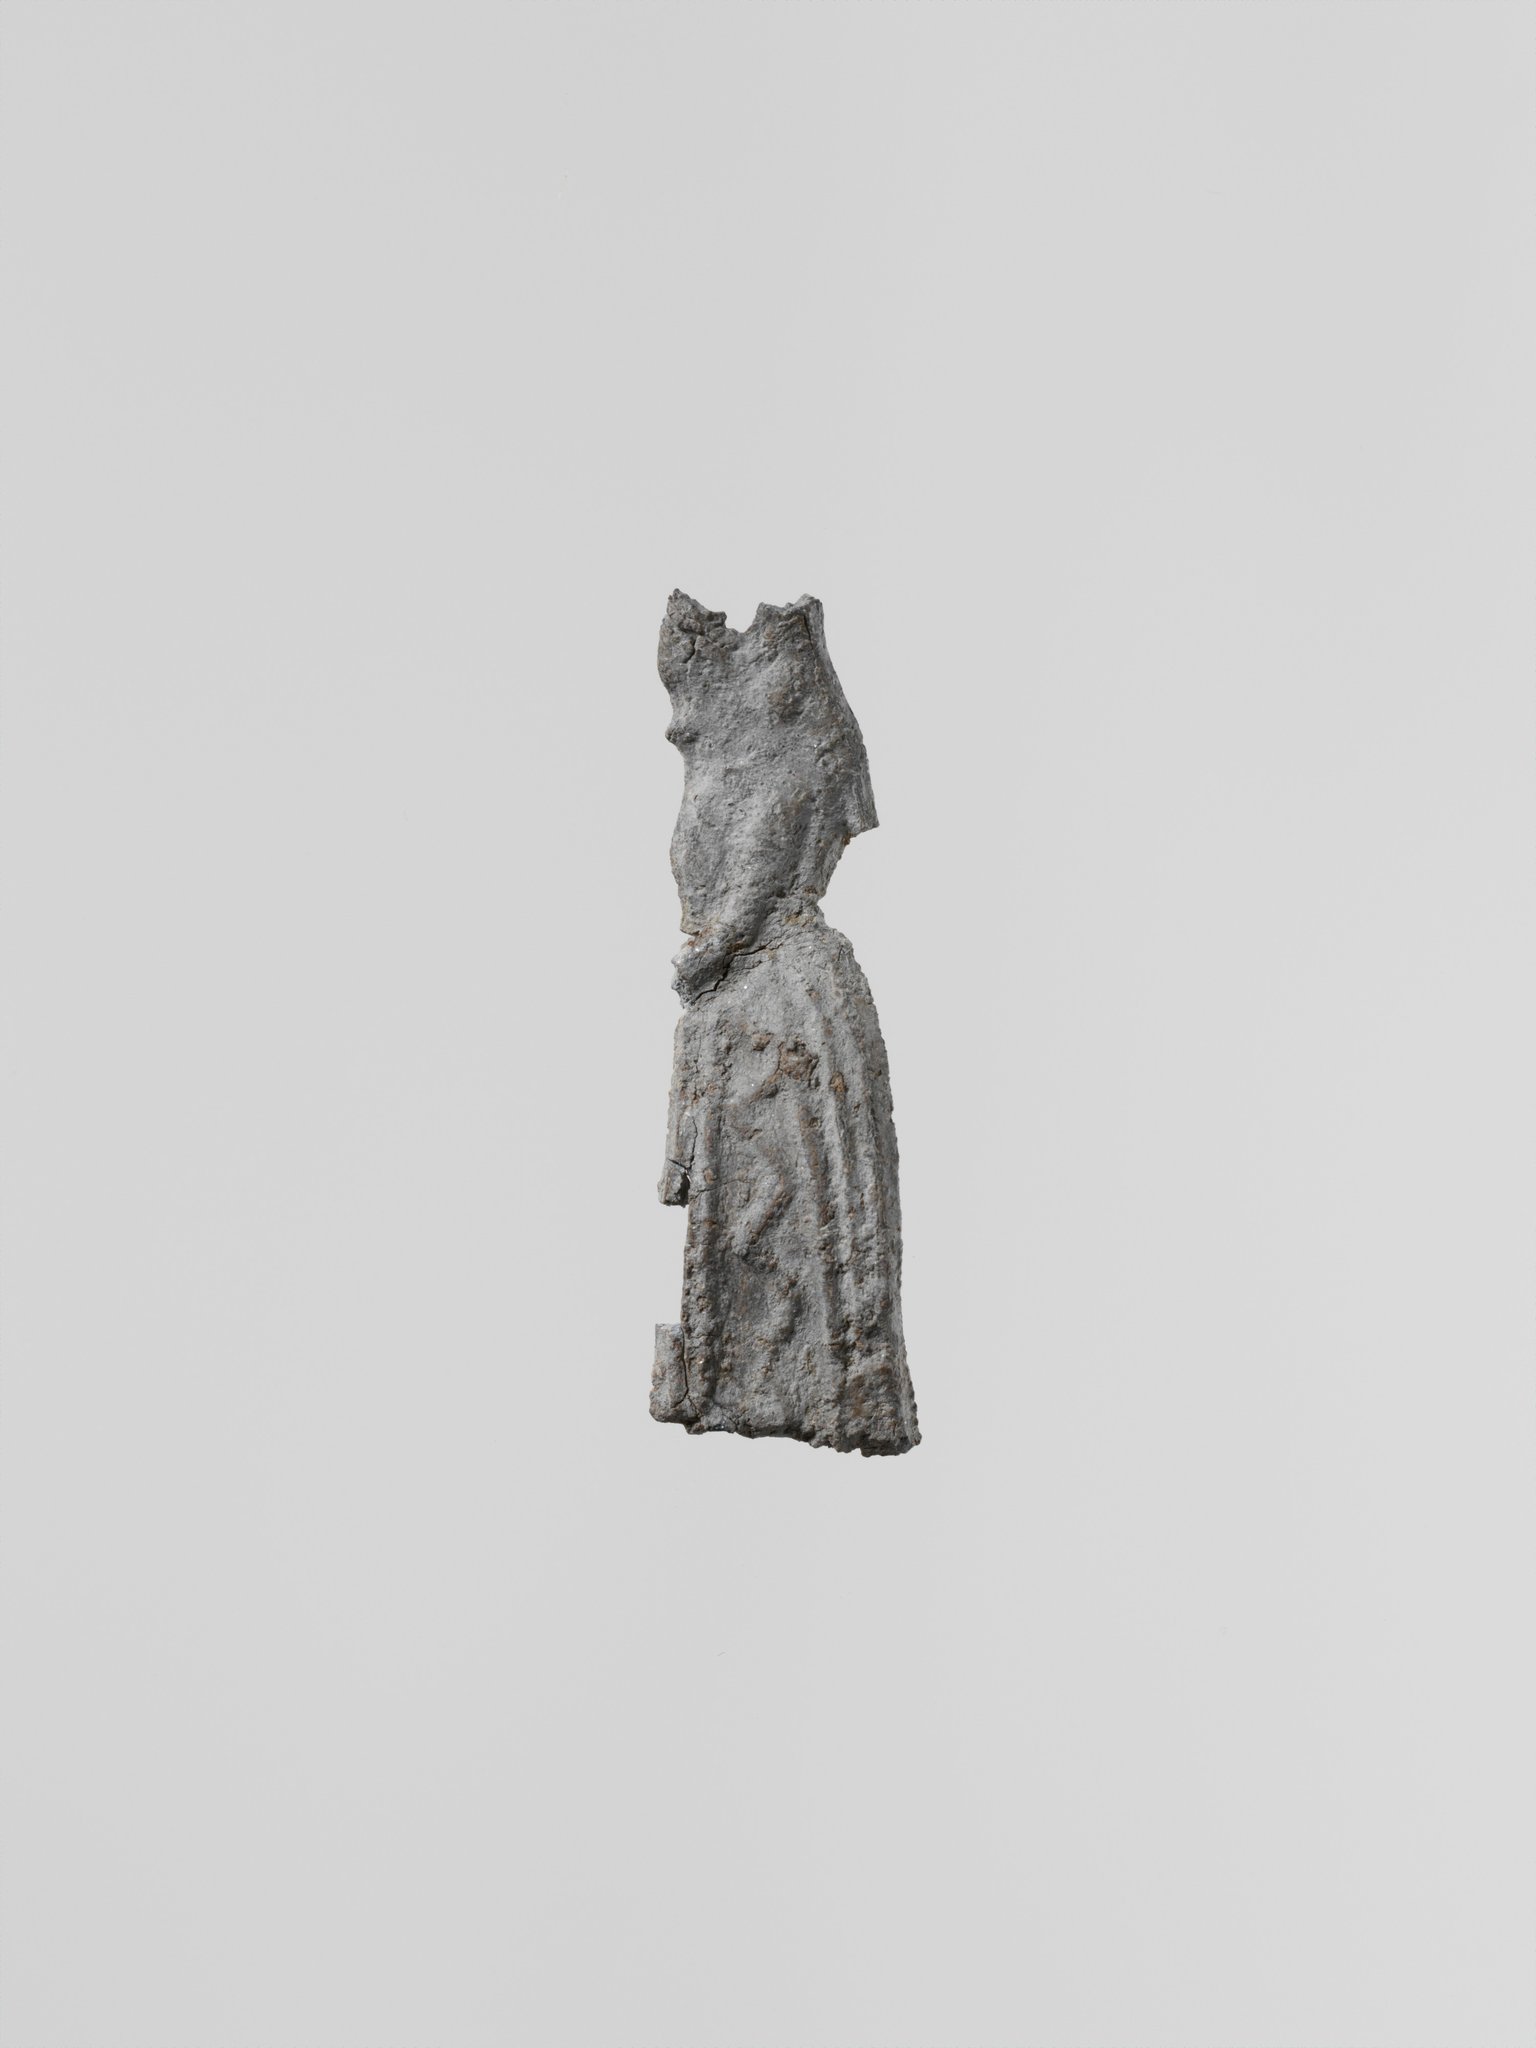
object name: statuette of a woman votary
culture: greek, laconian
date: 625-425 BCE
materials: lead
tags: women